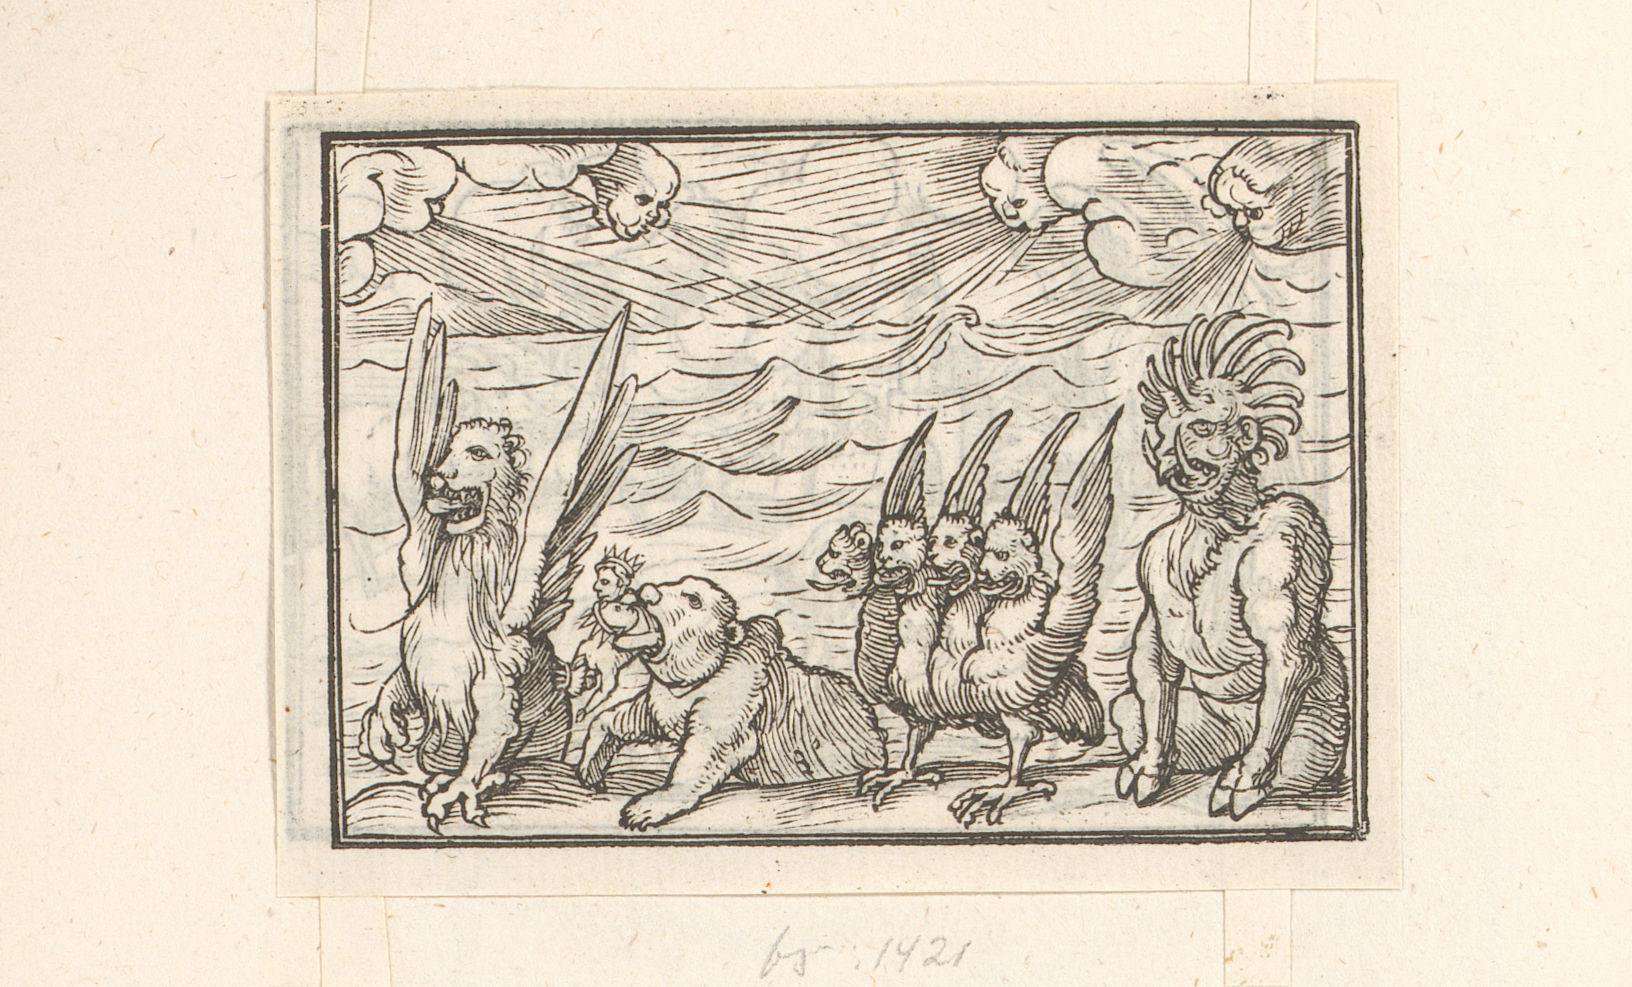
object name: album leaf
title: Visioen van Daniël van de vier beesten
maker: veit rudolf specklin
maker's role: print maker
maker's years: -1550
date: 1538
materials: paper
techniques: woodcut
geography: switzerland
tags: four great beasts rising from the sea ~ daniel's visions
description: Boekillustratie voor het eerst gebruikt in: Biblia Utriusque Testamenti iuxta Vulgatam Translationem, Lyon, M. en G. Trechsel (voor Hugo à Porta) 1538. Later in verschillende uitgaven opnieuw gebruikt. Deze prent vermoedelijk gebruikt in één van de uitgaven uitgegeven en/of gedrukt door Jean Frellon, Lyon.